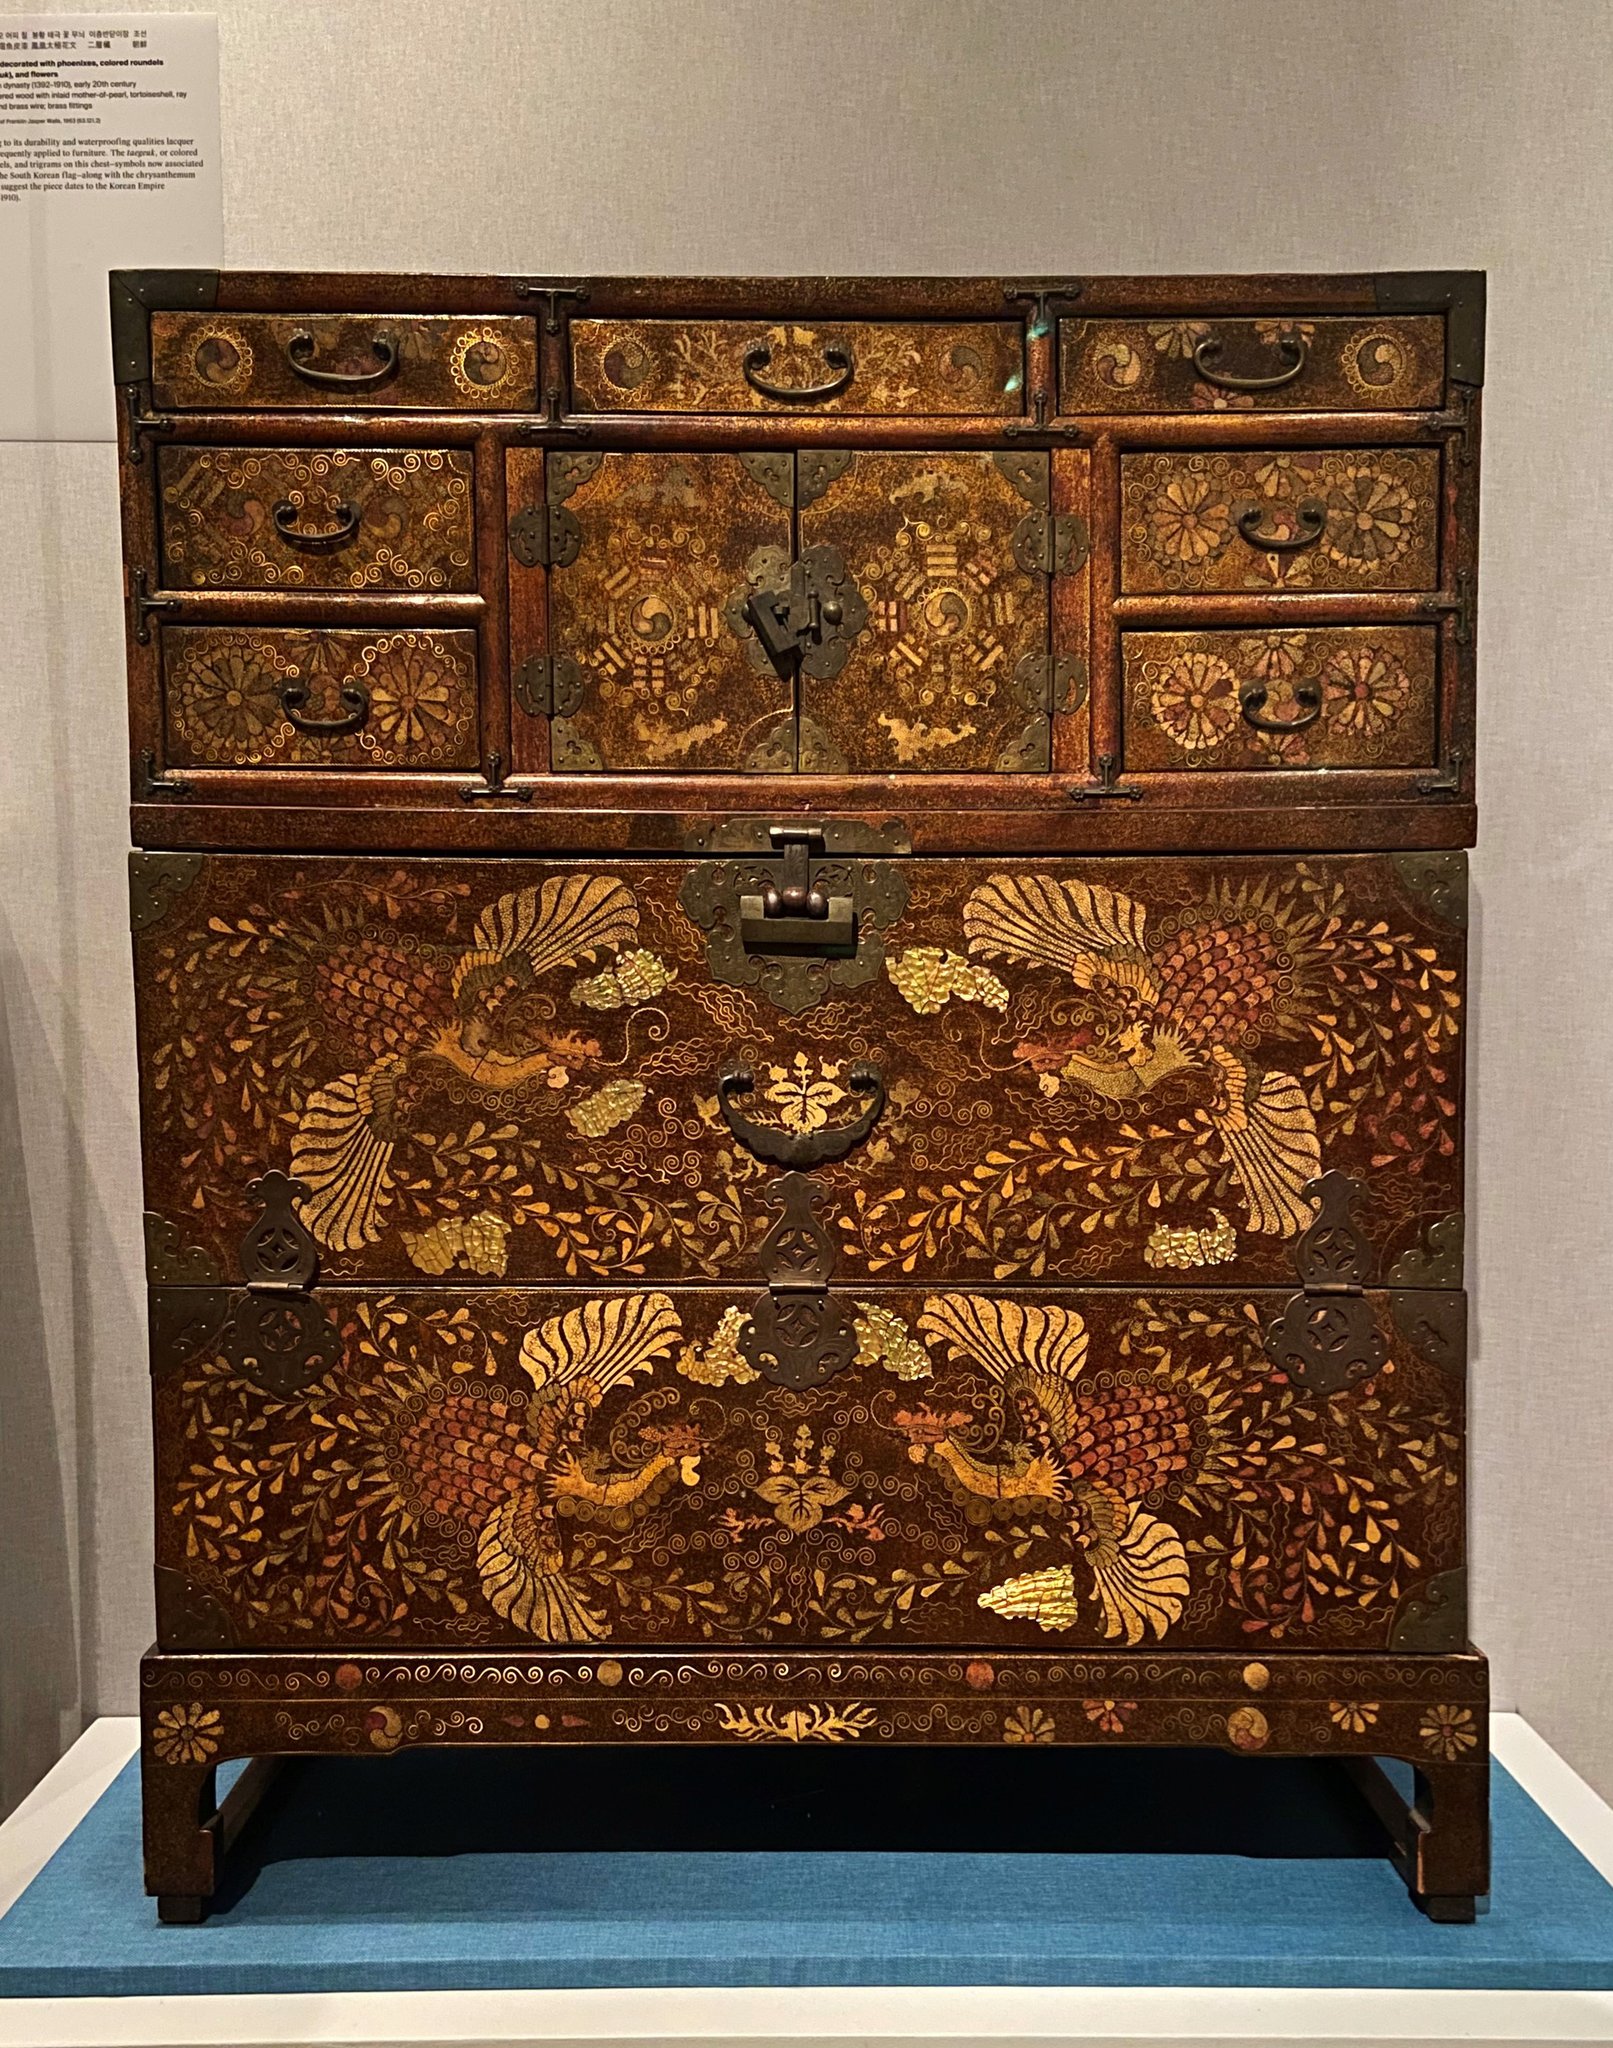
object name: chest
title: Chest decorated with phoenixes, colored roundels (taegeuk), and flowers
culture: korean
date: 1901-1933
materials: brass, mother of pearl, skin, shell, metal, wood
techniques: inlay, lacquer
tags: mythical creatures,flowers,leaves,chests